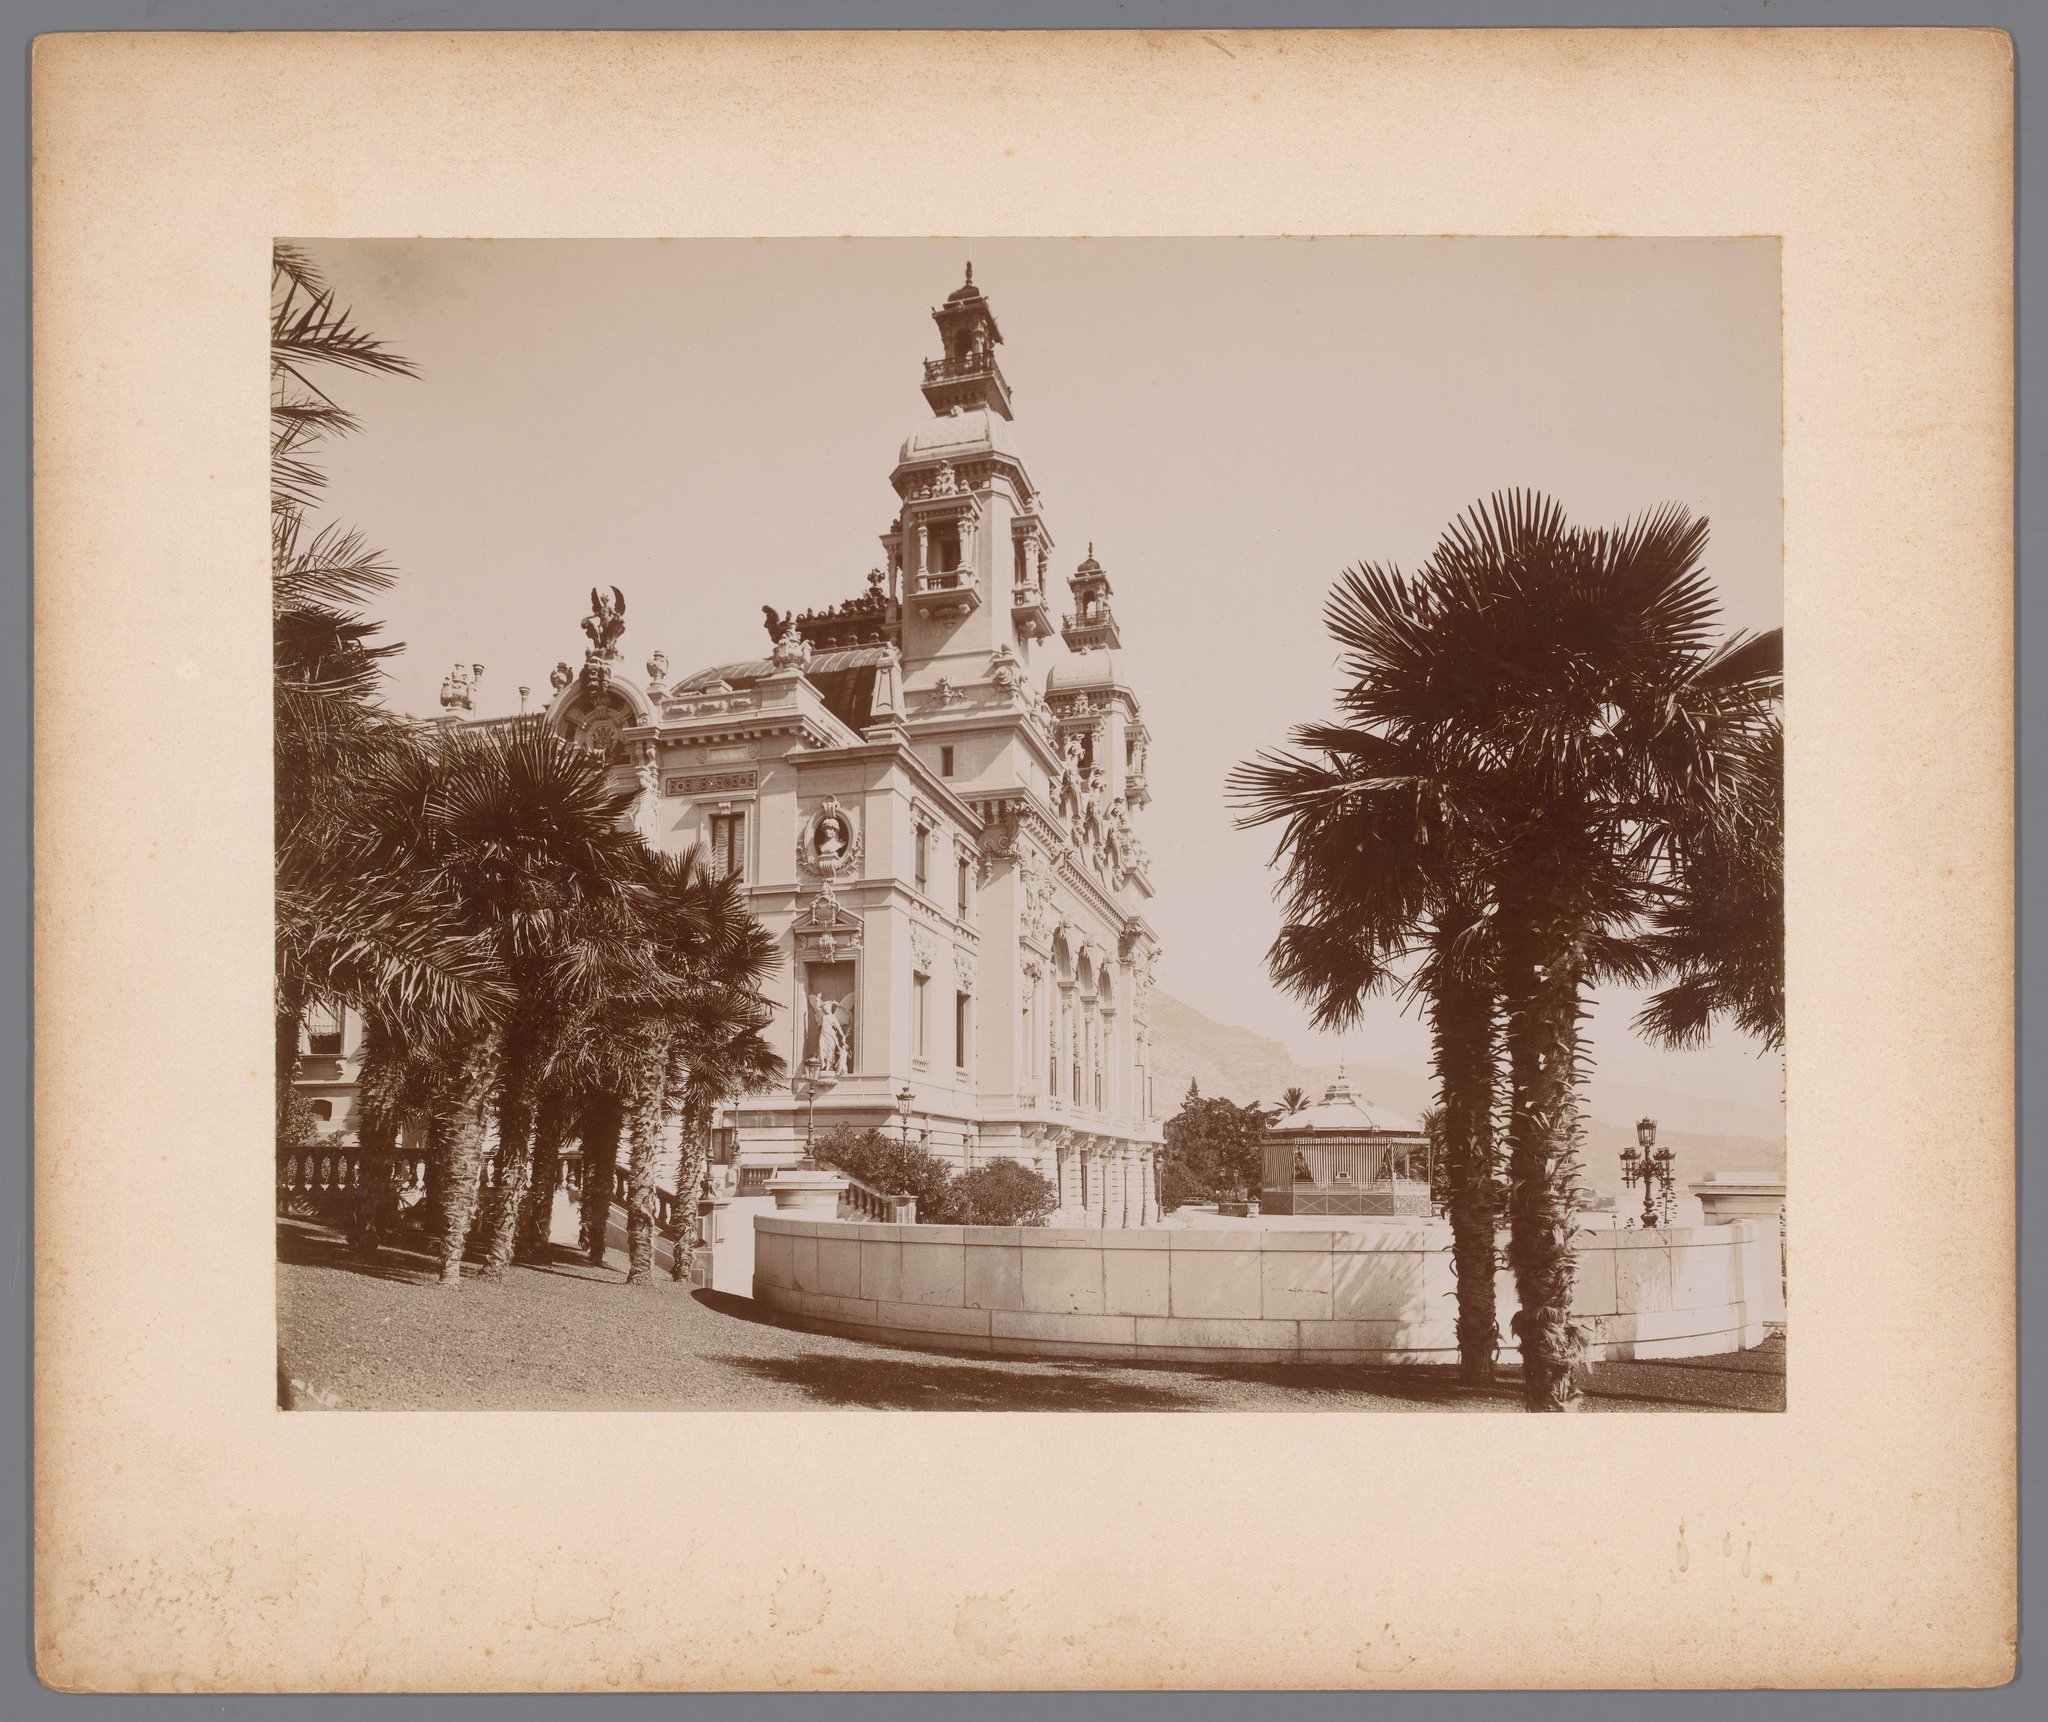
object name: photograph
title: Kerk met palmbomen ervoor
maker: Anonymous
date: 1875-1910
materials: cardboard, photographic support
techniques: gelatin silver print